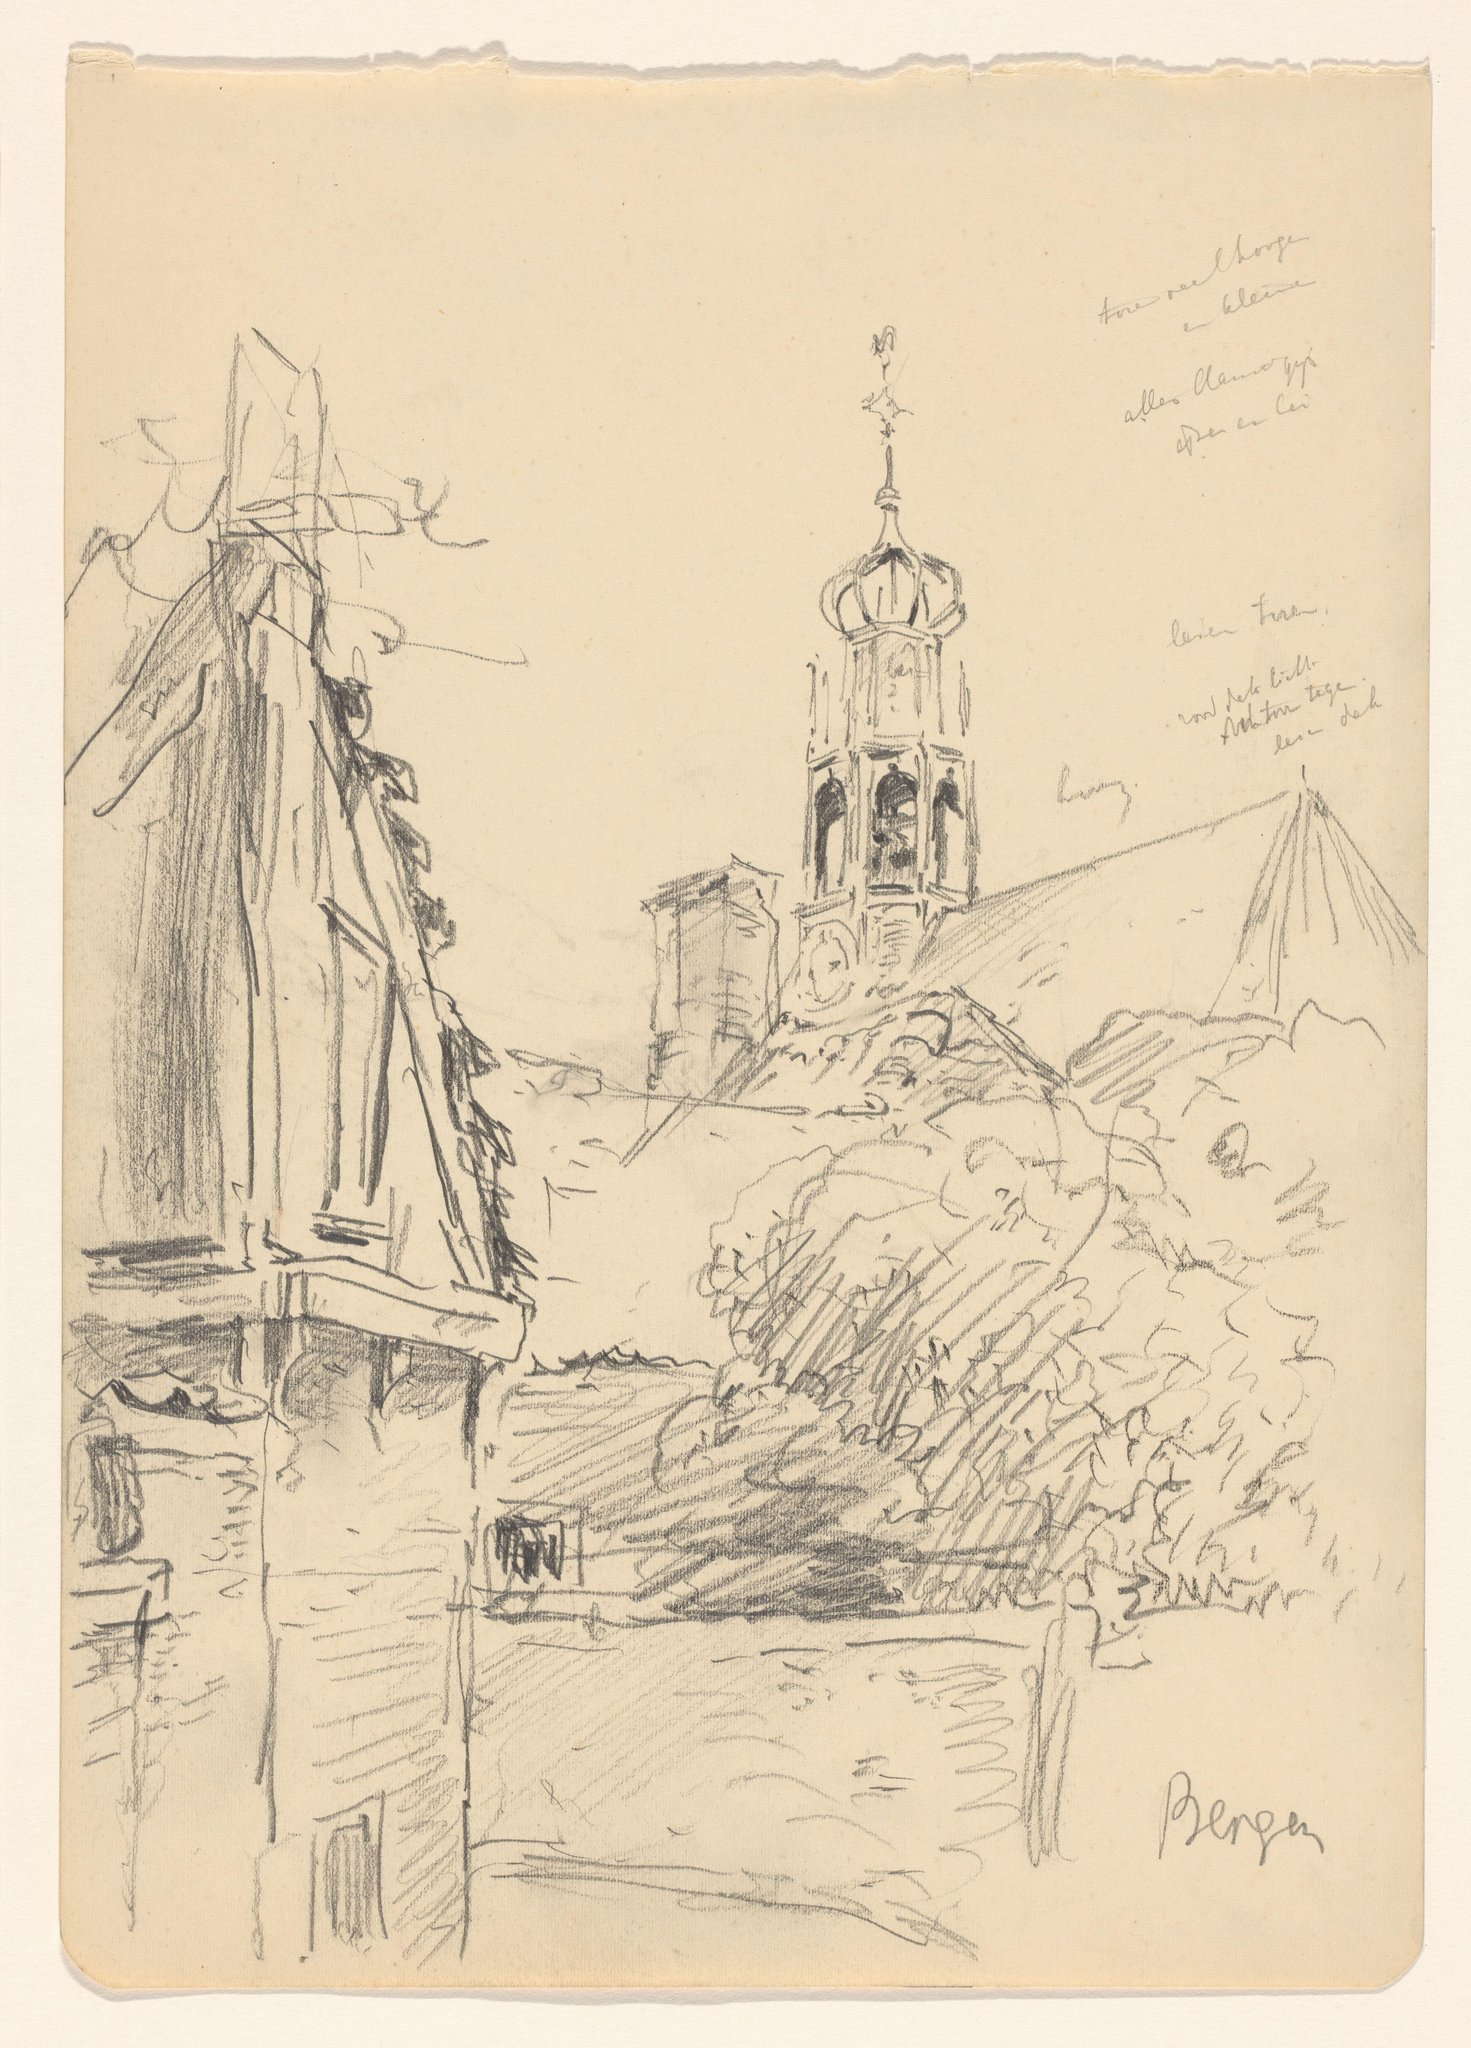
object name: drawing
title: Gezicht op de Ruïnekerk te Bergen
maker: jan hoynck van papendrecht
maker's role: draughtsman, painter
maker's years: 1858-1933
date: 1868-1933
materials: paper, pencil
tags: church (exterior)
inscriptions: annotation: ‘toren veel hoger (...) Bergen’, collector's mark: Lugt 2228